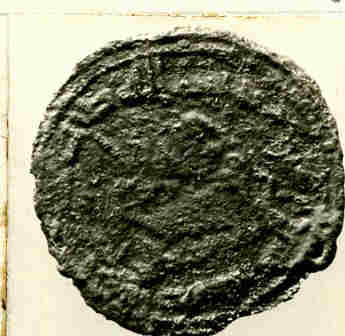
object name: coin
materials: copper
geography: iran